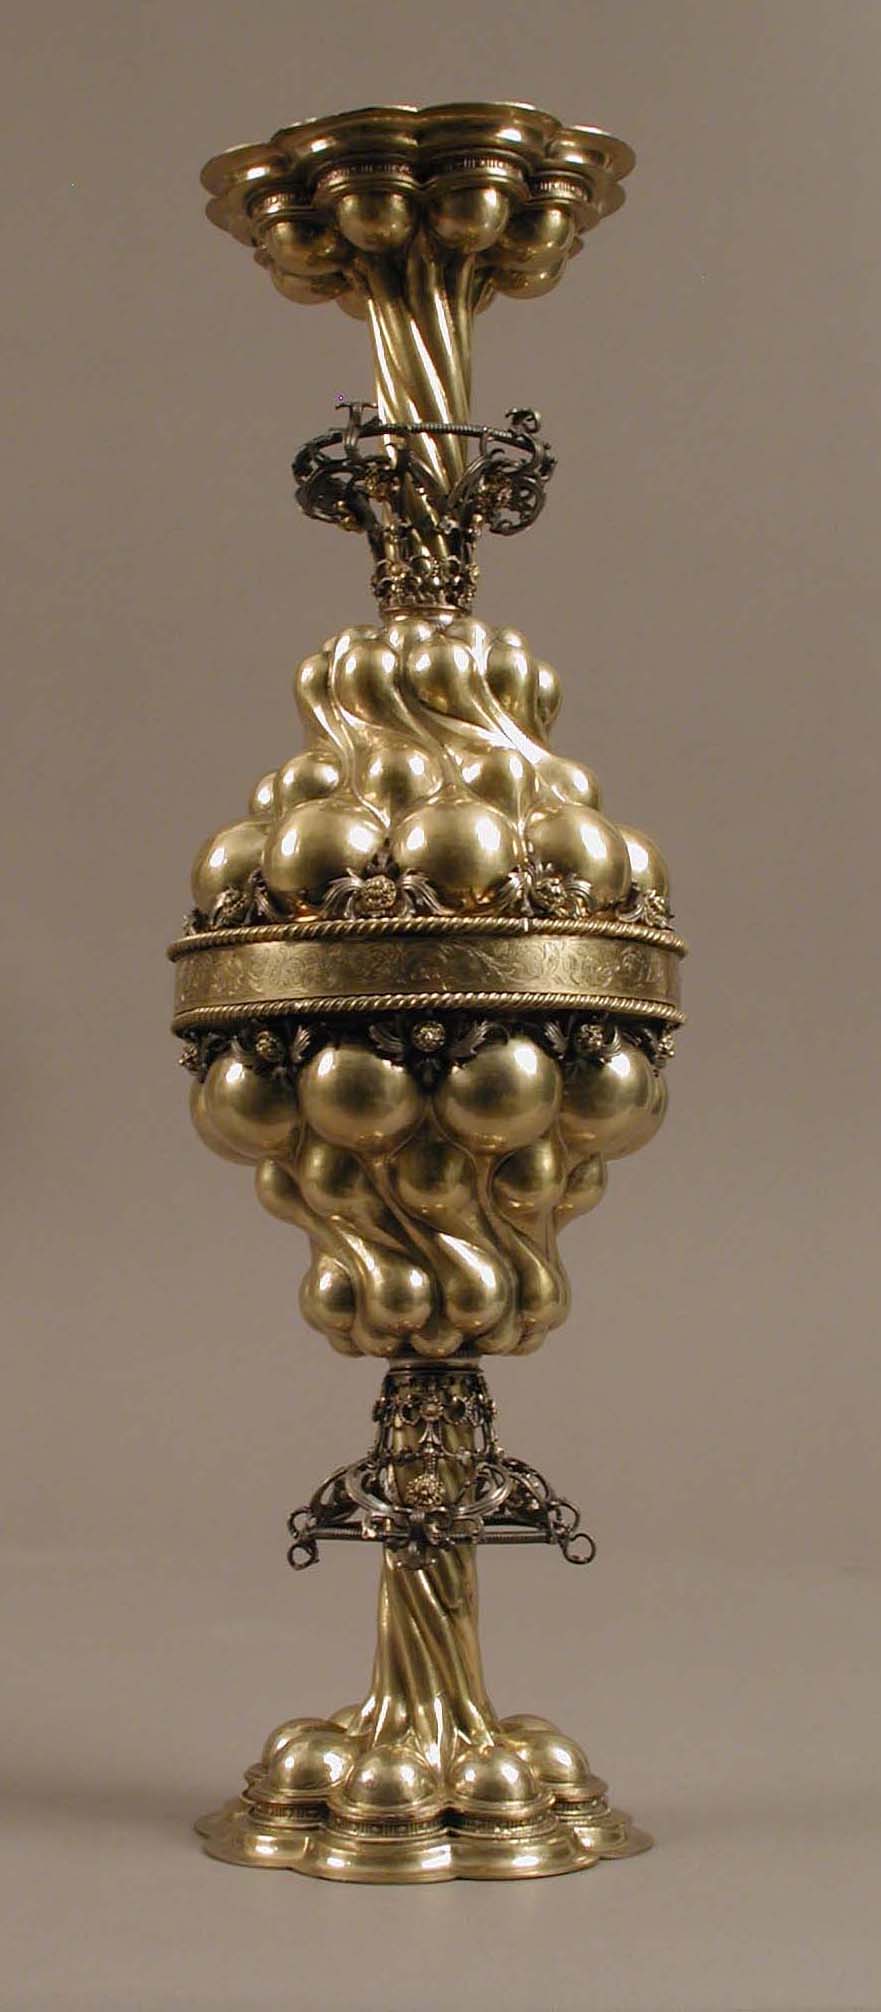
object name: cup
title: Double Cup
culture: german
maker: caspar beutmüller the elder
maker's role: artist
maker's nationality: german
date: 1590-1600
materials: glass, gold, silver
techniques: gilding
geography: germany